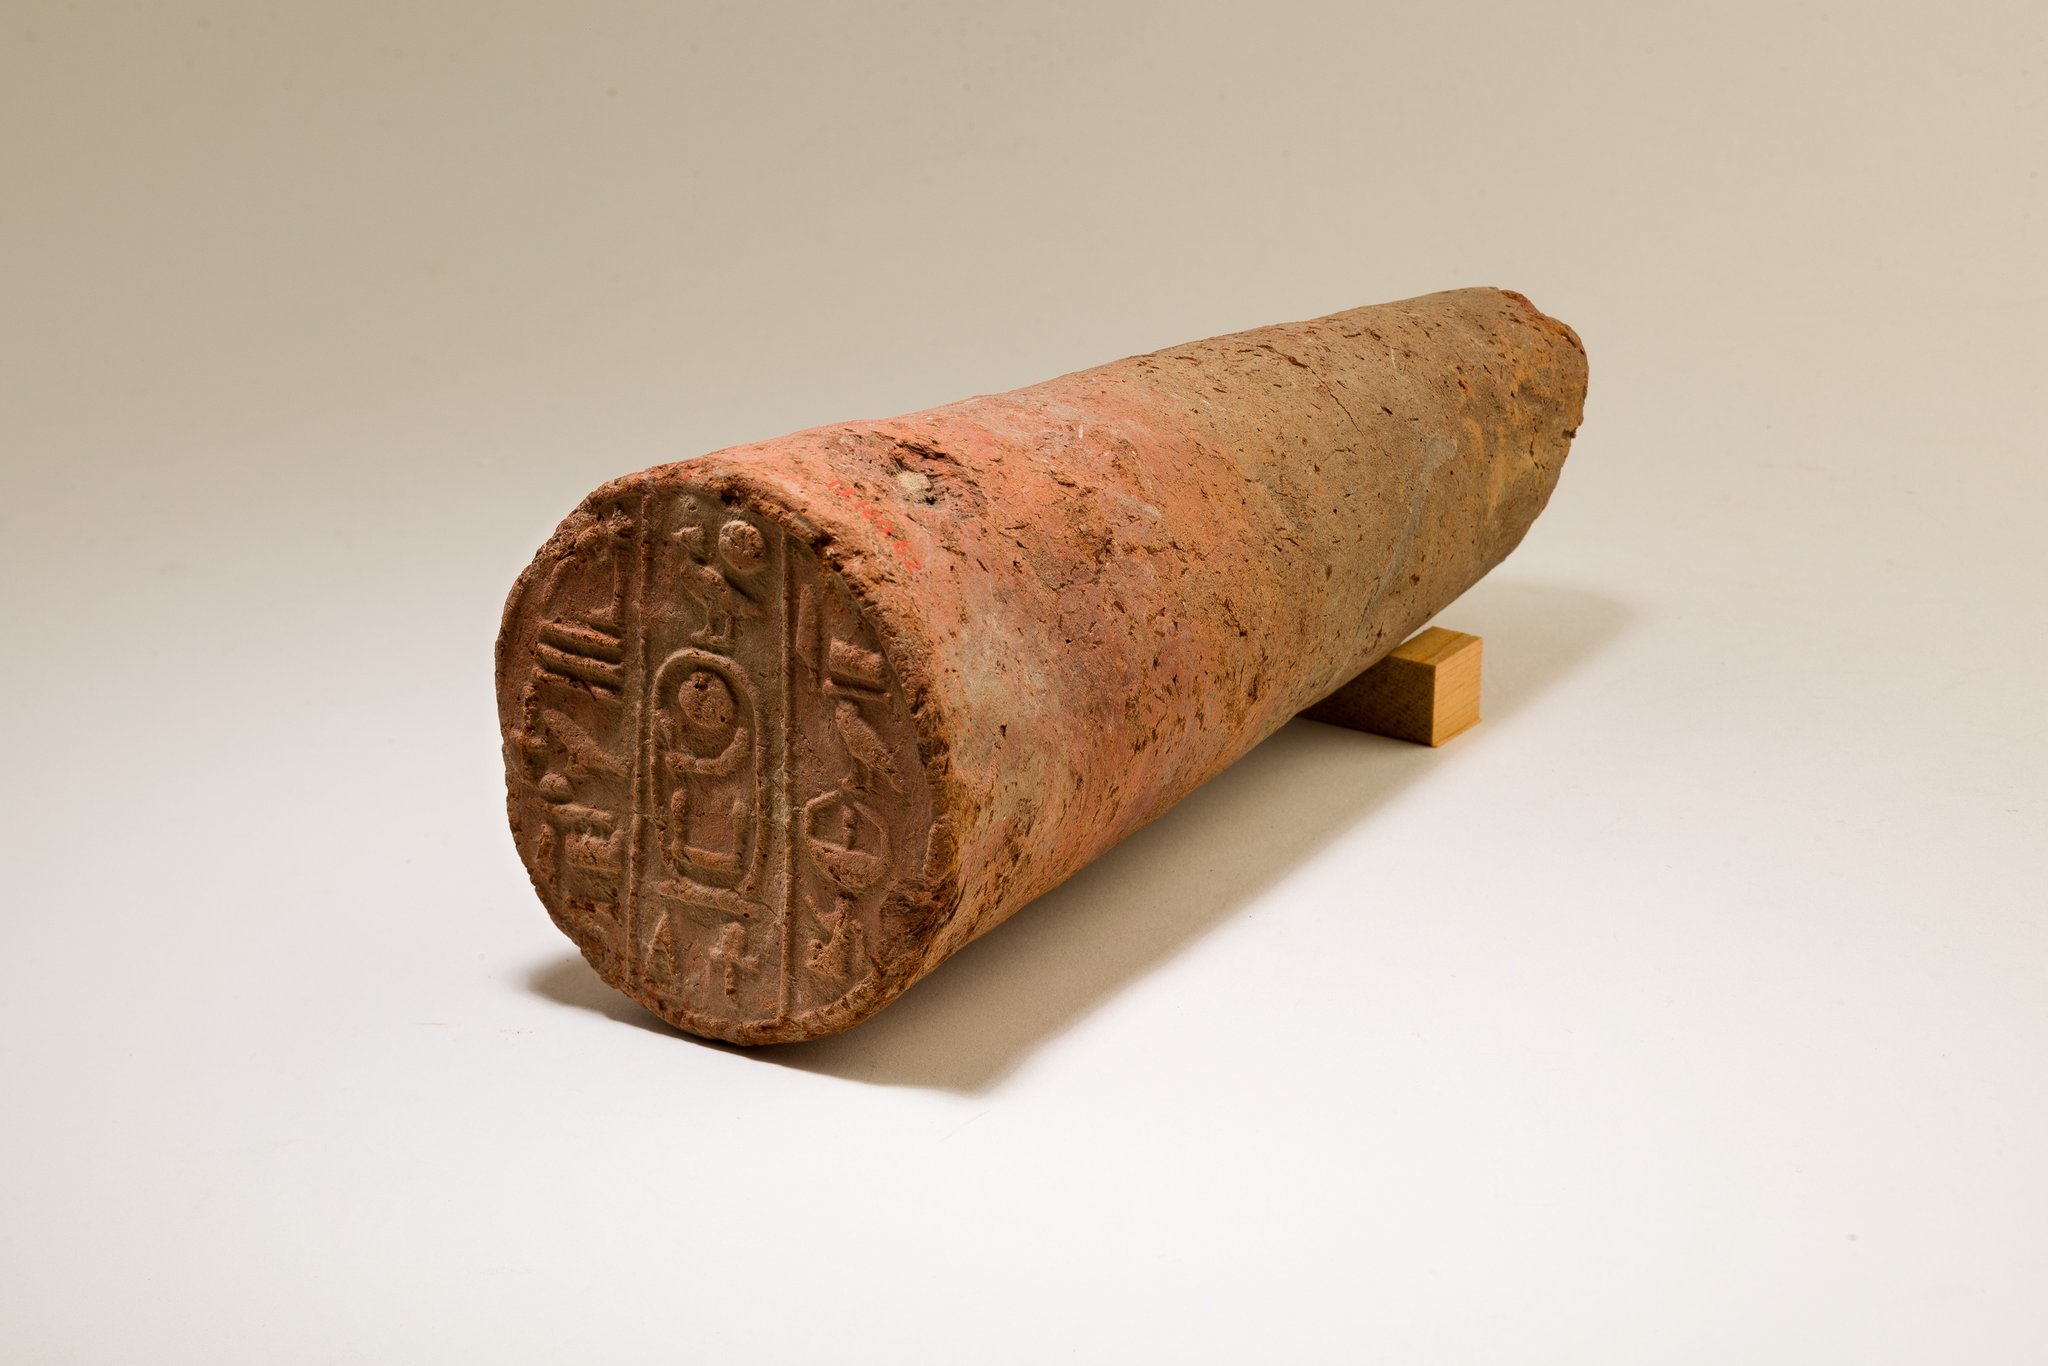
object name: cone, circular impression, amenemhab, wab priest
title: Funerary Cone of the Wab-Priest Amenemhab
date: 1525-1504 BCE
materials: pottery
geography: egypt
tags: hieroglyphs